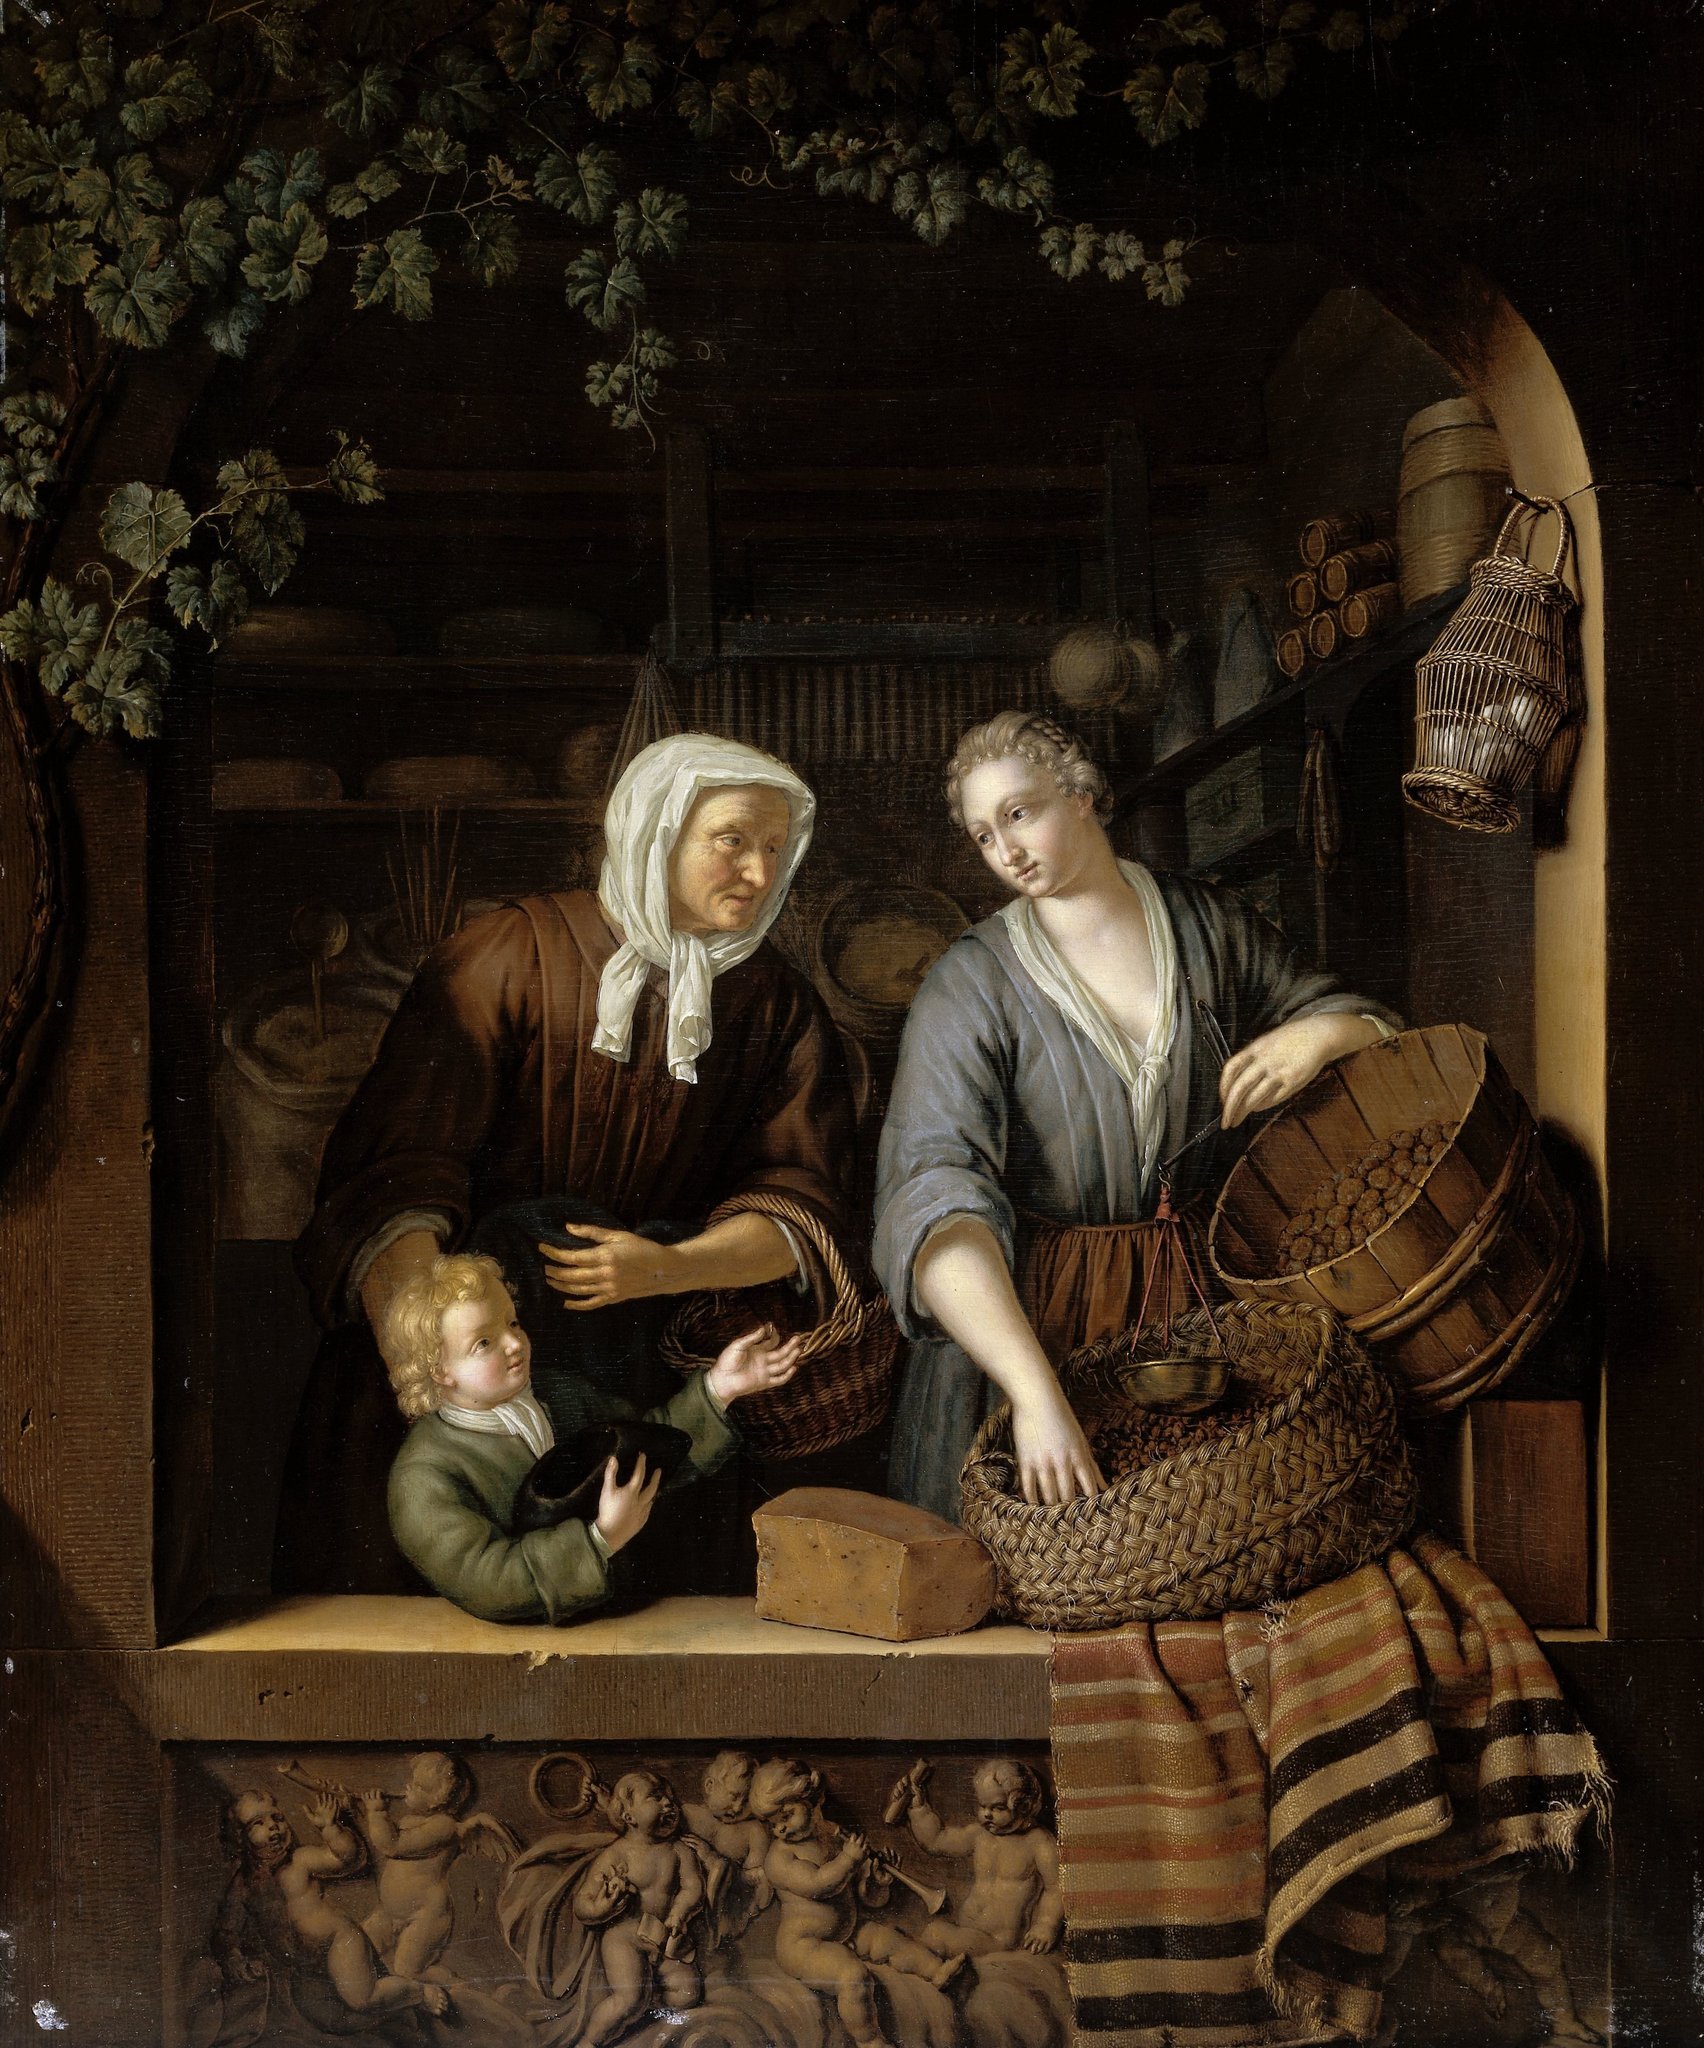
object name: painting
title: The Grocer’s Shop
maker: frans van mieris (ii)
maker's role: draughtsman, painter, print maker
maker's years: 1689-1763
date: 1715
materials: oil, panel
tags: shop, store, persons engaged in trade and commerce - bb - women engaged in trade and commerce, human figure at (open) window, seen from outside, marketing, shopping (~ household management)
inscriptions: signature and date: ‘F. V. Mieris. Fec. Aº 1715.’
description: The painter of this scene, Frans II, was the youngest member of the artistic Van Mieris family. He followed firmly in the footsteps of his grandfather Frans I and his father, Willem. Hence, this painting can serve as a pendant to The Poultry Seller painted by his father (on view elsewhere on this wall). The egg basket at the upper right appears to have descended through the generations.